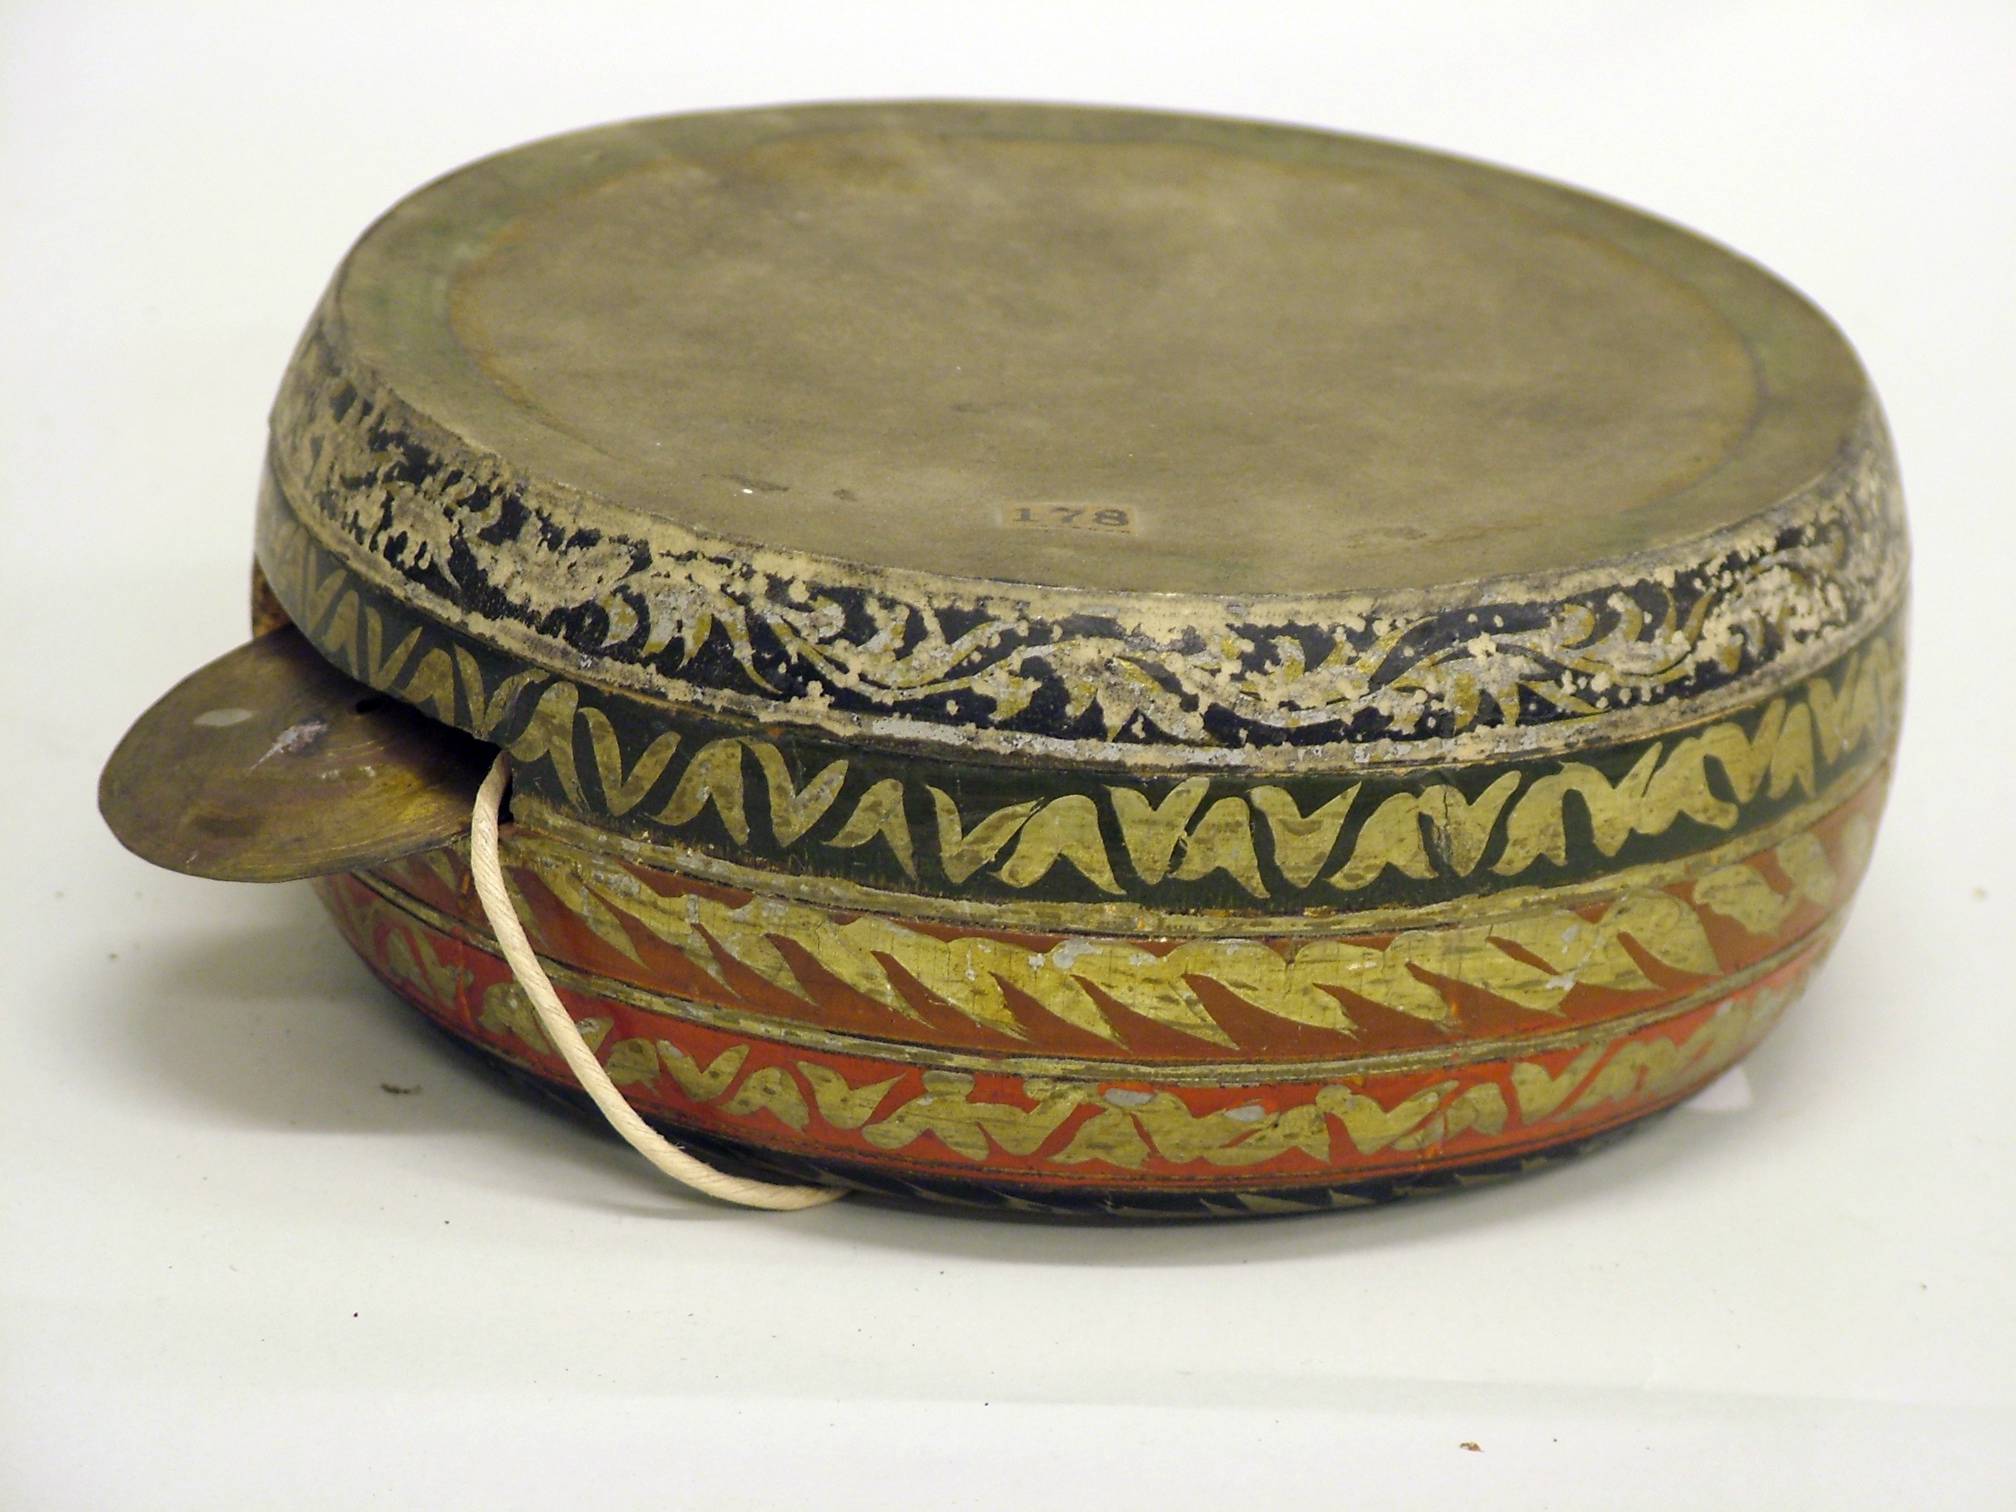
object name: khanjari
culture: indian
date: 1885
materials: metal, skin, wood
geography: india